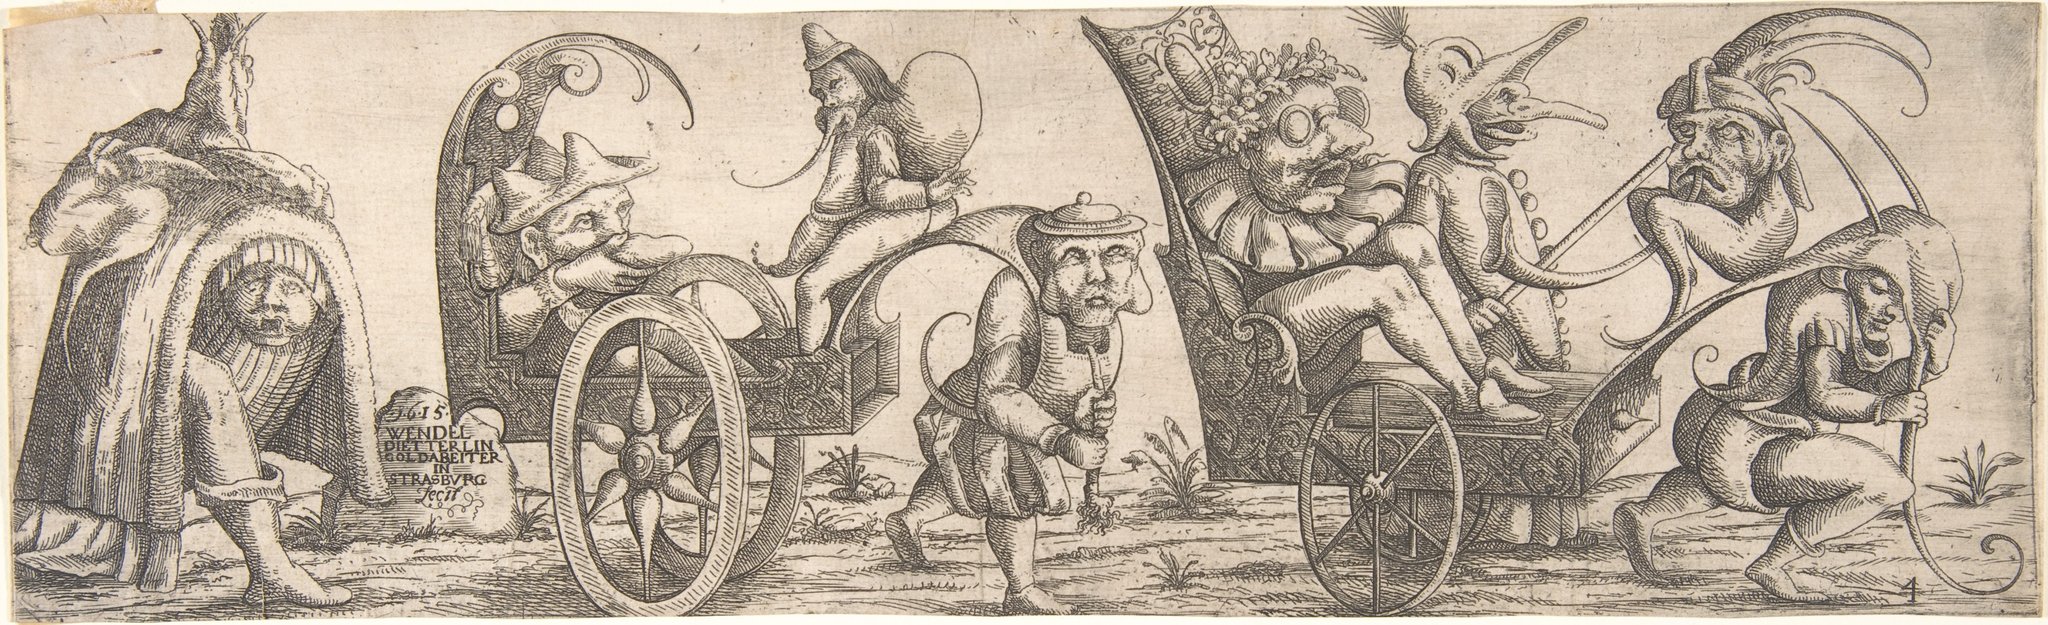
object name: print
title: Procession of Monstrous Figures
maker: wendel dietterlin, the younger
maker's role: artist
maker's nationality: german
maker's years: 1614-1669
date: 1615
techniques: etching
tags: monsters,carriages